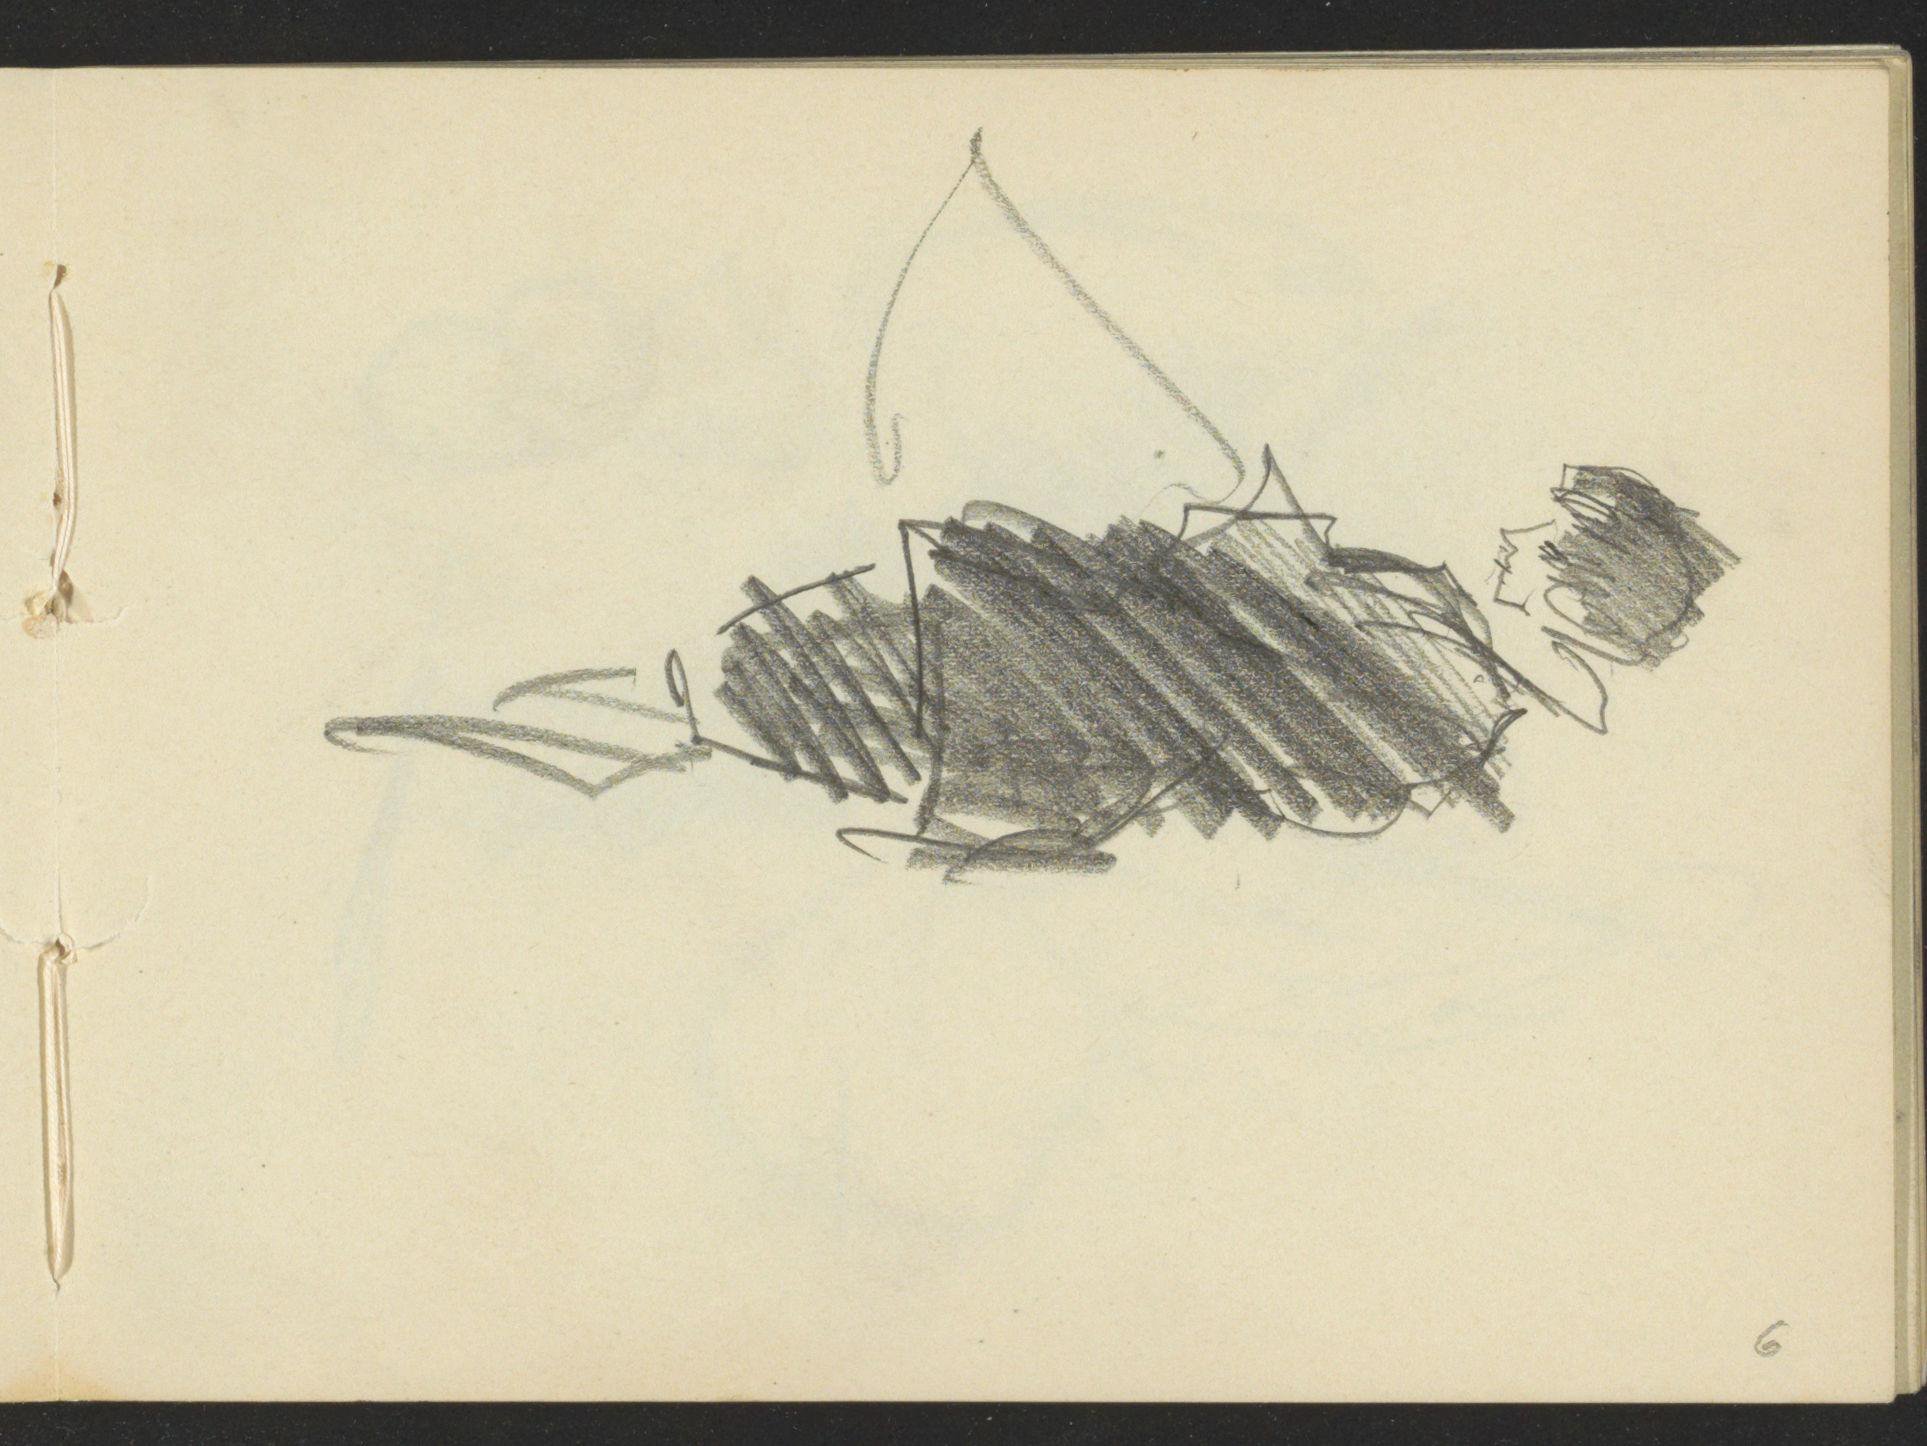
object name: sketchbook leaf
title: Staande figuur, in profiel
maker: isaac israels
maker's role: draughtsman, painter, print maker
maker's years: 1865-1934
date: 1875-1934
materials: paper, pencil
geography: the hague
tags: standing figure (+ sideview, profile)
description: Blad 6 recto uit schetsboek LXV met 27 bladen.